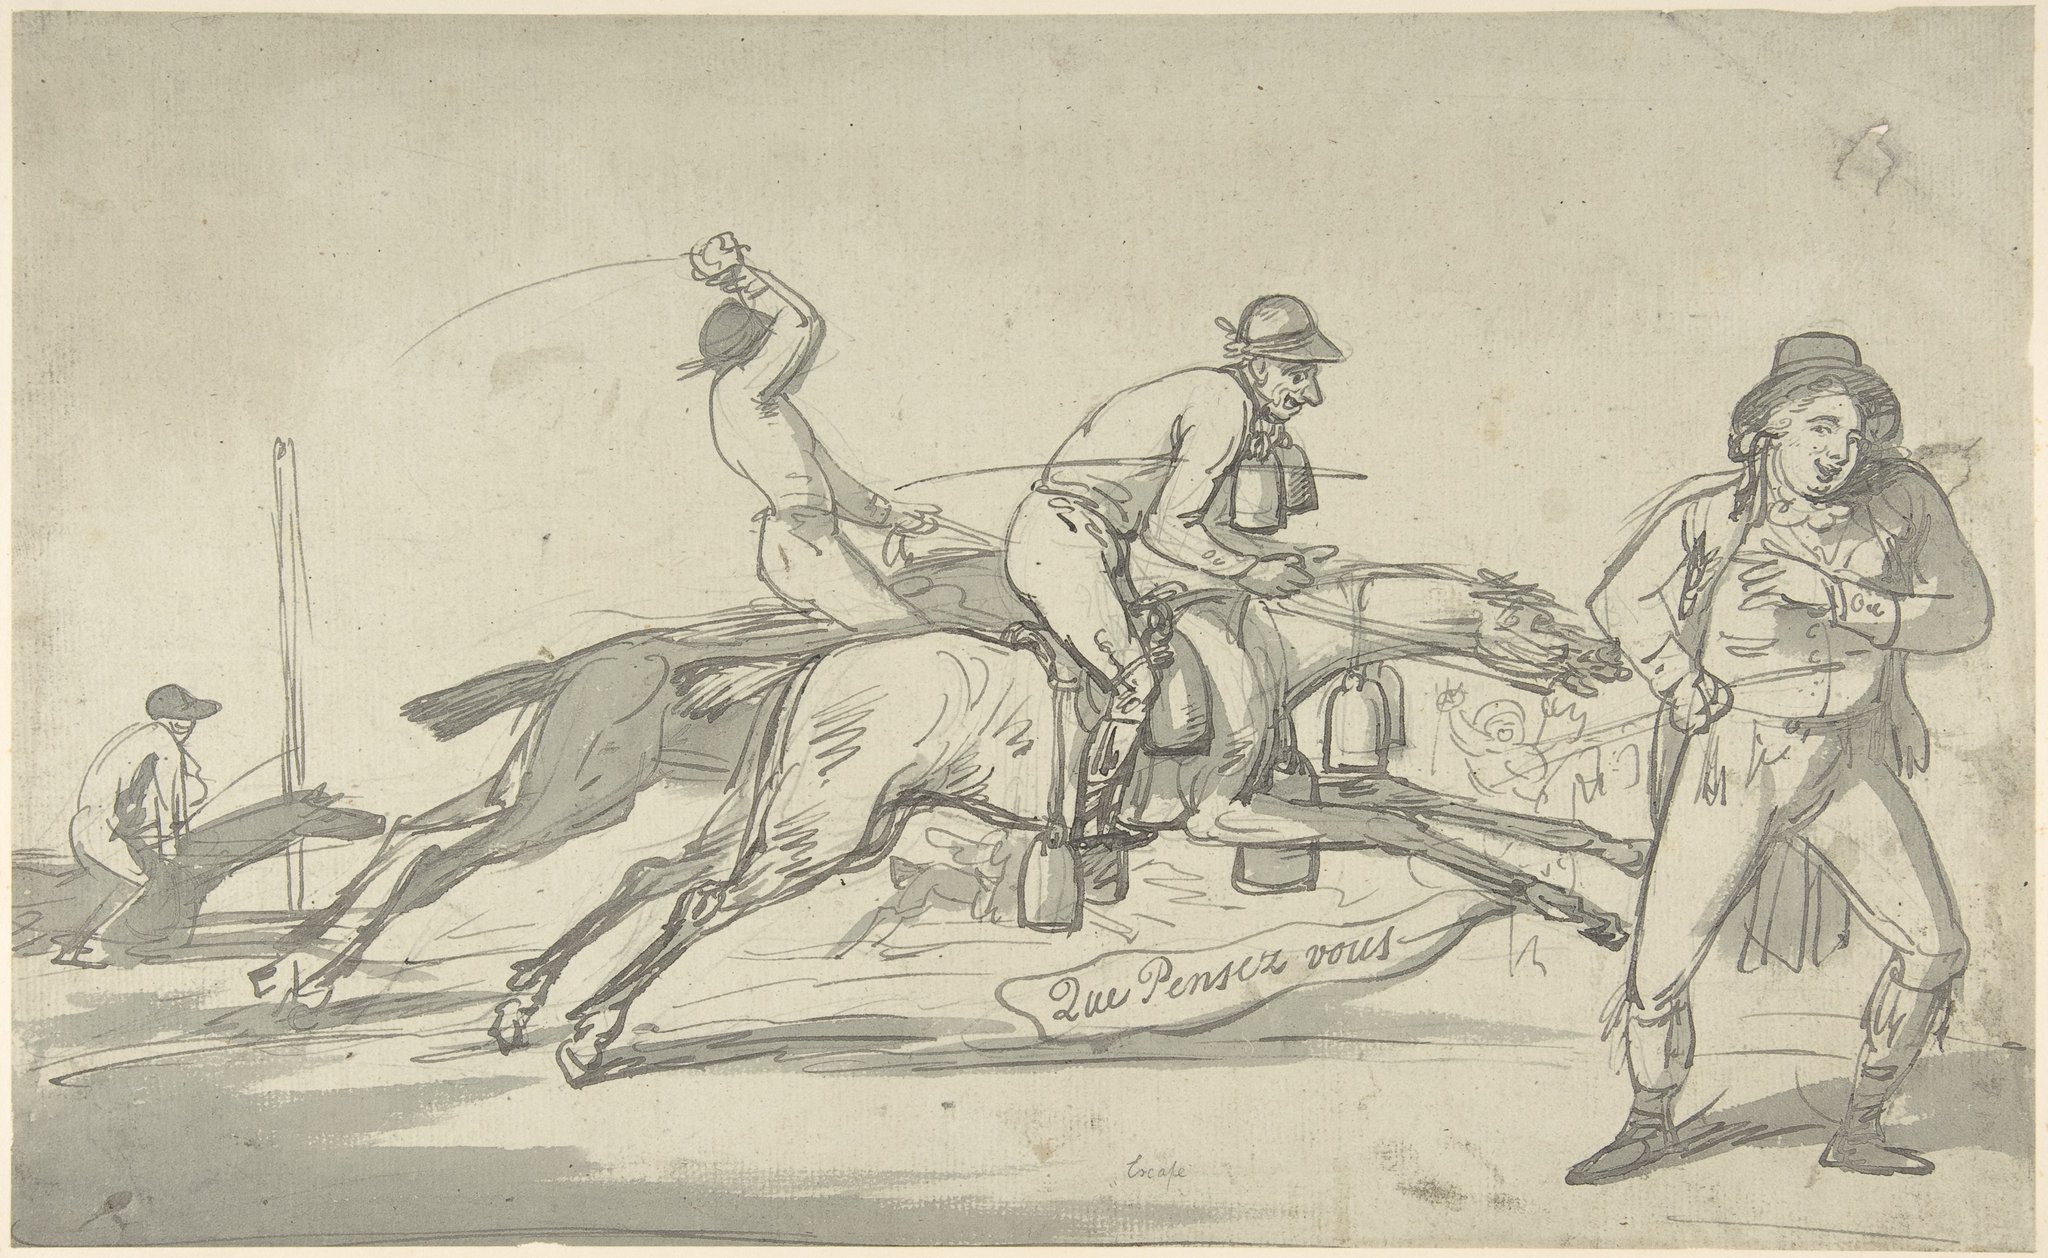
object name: drawing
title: How to Escape Losing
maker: thomas rowlandson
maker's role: artist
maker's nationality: british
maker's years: 1757-1827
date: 1791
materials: ink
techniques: brush, pen, wash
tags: men,horses